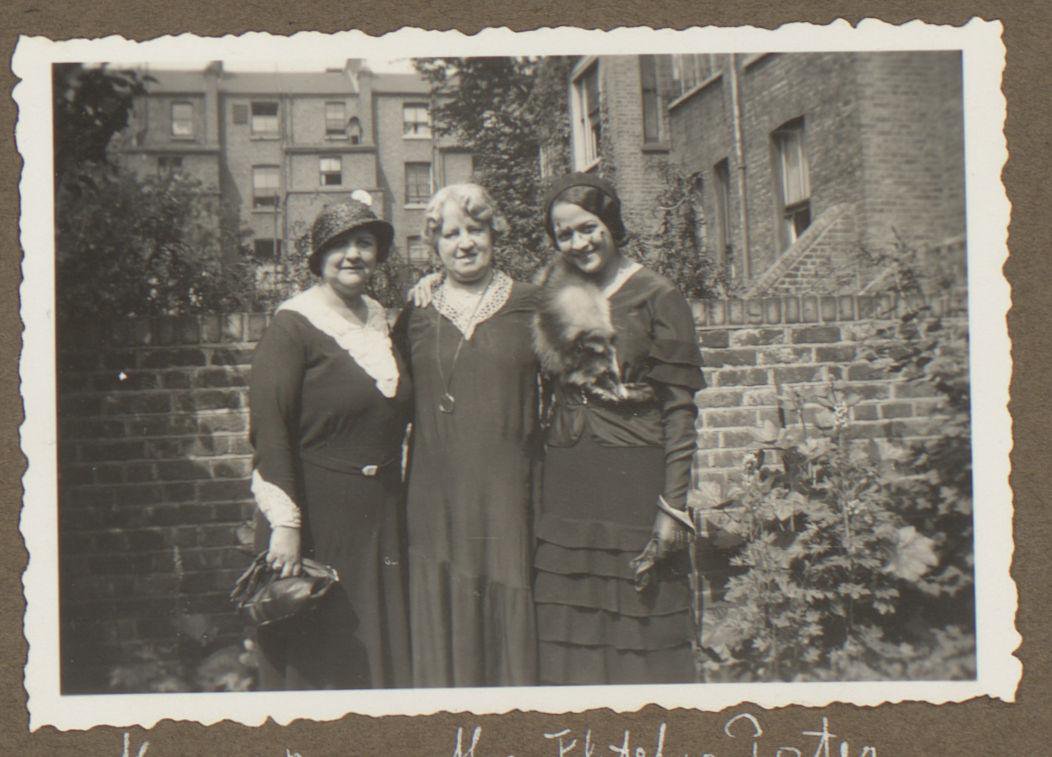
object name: album leaf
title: Portret van Henriëtte van Bergen, mevrouw Fletcher Porter en Wilhelmina van Zijll de Jong, Londen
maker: Anonymous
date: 1906-1932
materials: paper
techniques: gelatin silver print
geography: london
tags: wilhelmina van zijll de jong, historical persons - bb - woman, london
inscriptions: inscription: ‘Mevr. v. Bergen, Mrs Fletcher Porter/ 49 Lexington Gardens/ South Kensington.’